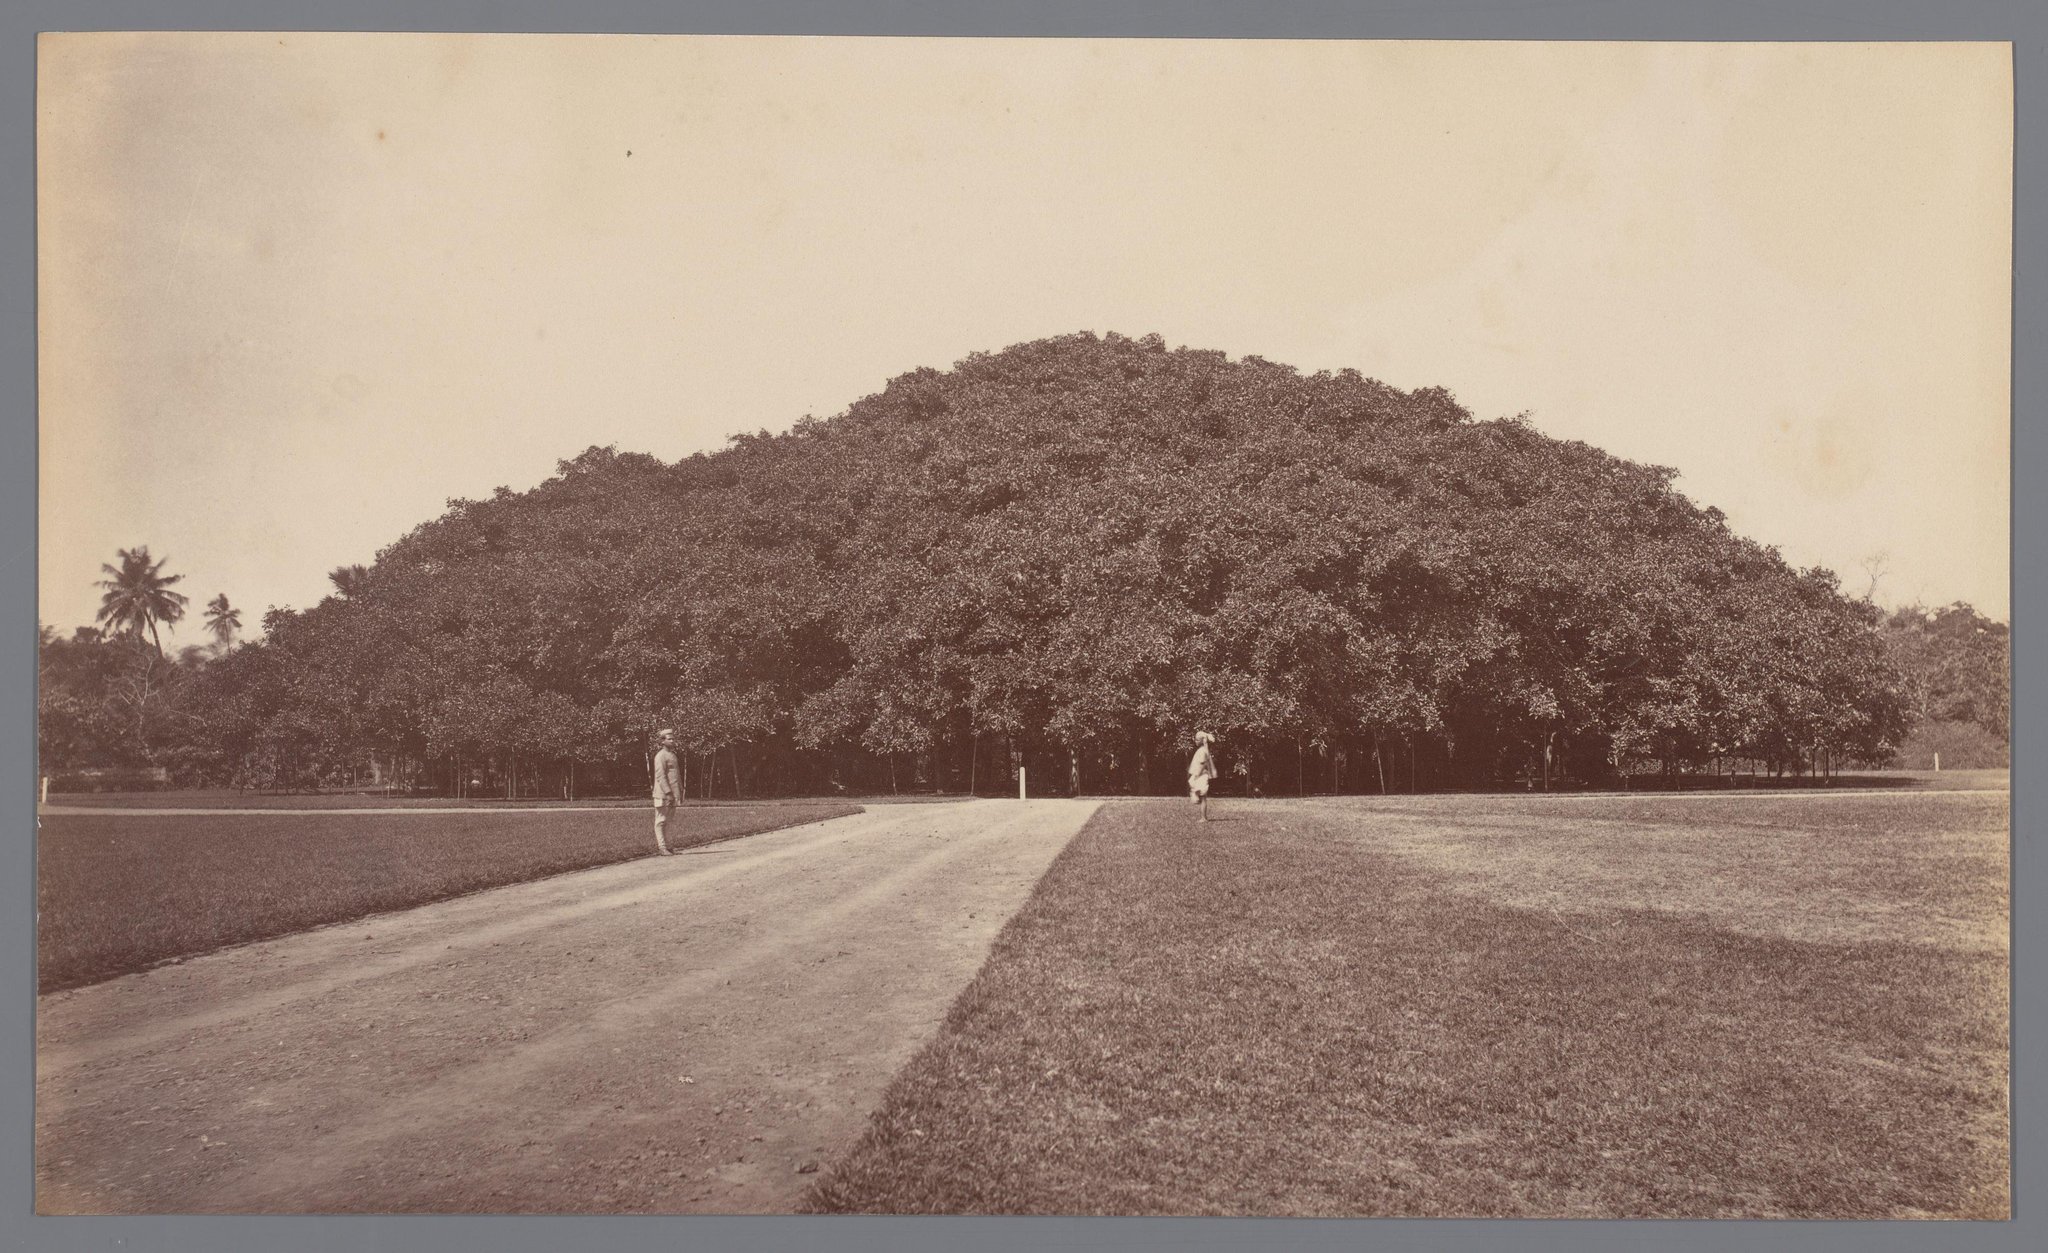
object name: photograph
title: Botanical garden, Kolkata, West Bengal, India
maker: samuel bourne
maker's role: fotograaf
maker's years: 1834-1912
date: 1863-1870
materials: photographic support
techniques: albumen print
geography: kolkata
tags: kolkata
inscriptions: inscription: ‘Nr 1226/ Anon/ att. to Samuel/ Bourne’, inscription: ‘Calcutta/ The Jaca[?] Banyan tree in the Botanical Gardens’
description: Landschap met enorme bomen [Jacaranda bomen?] en twee figuren die links en rechts van een weg staan (geposeerd).